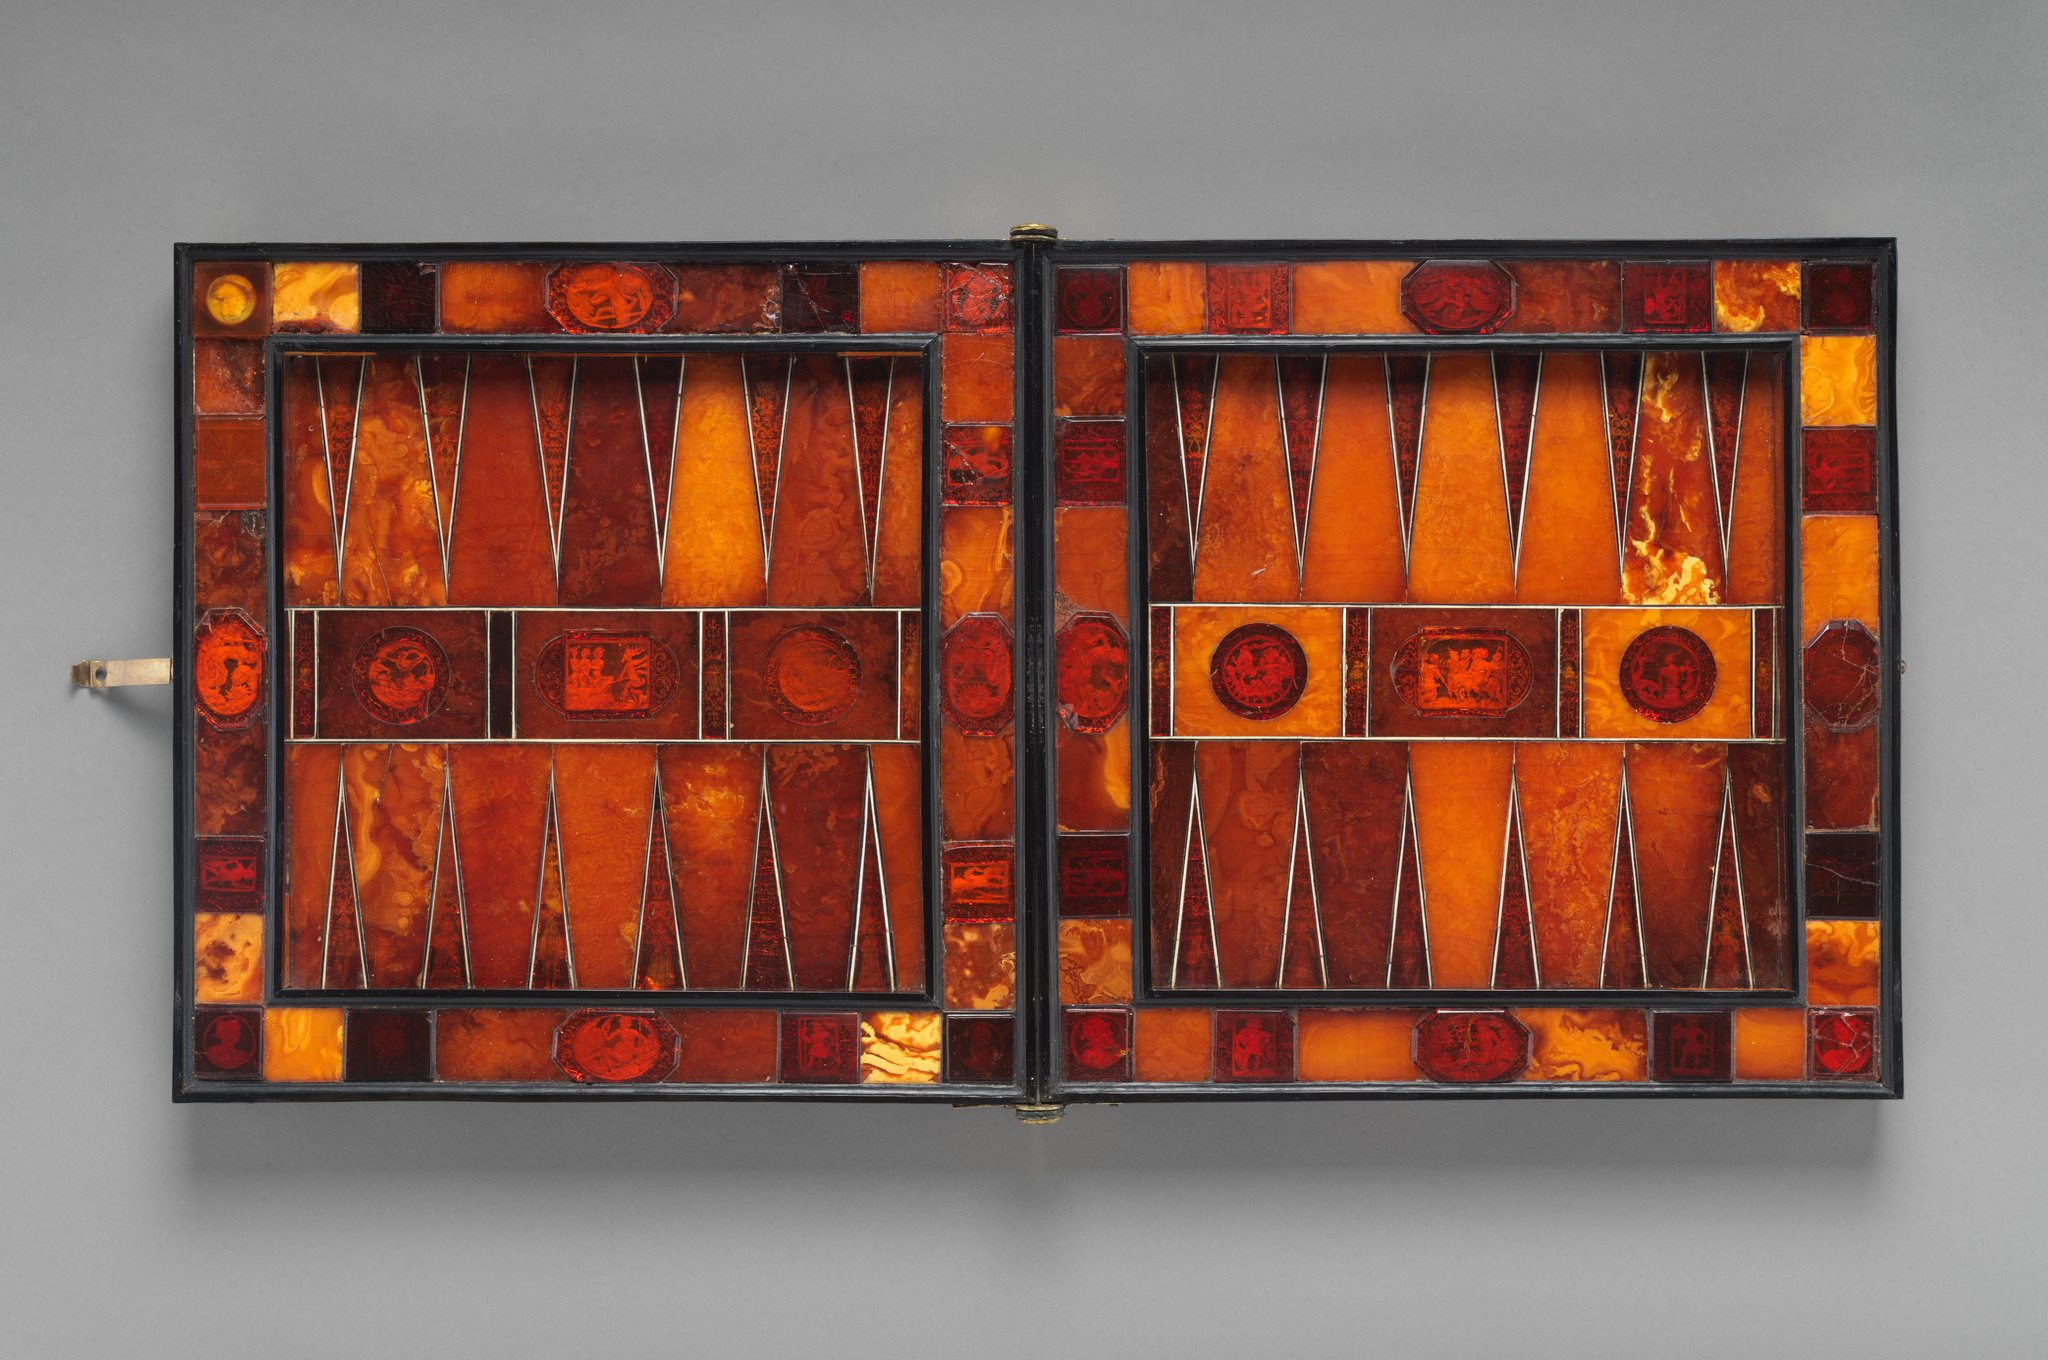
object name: chess and backgammon board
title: Chess and backgammon game board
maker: georg schreiber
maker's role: maker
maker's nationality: german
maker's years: 1616-1643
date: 1601-1700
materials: amber, brass, wood, gold foil, ivory